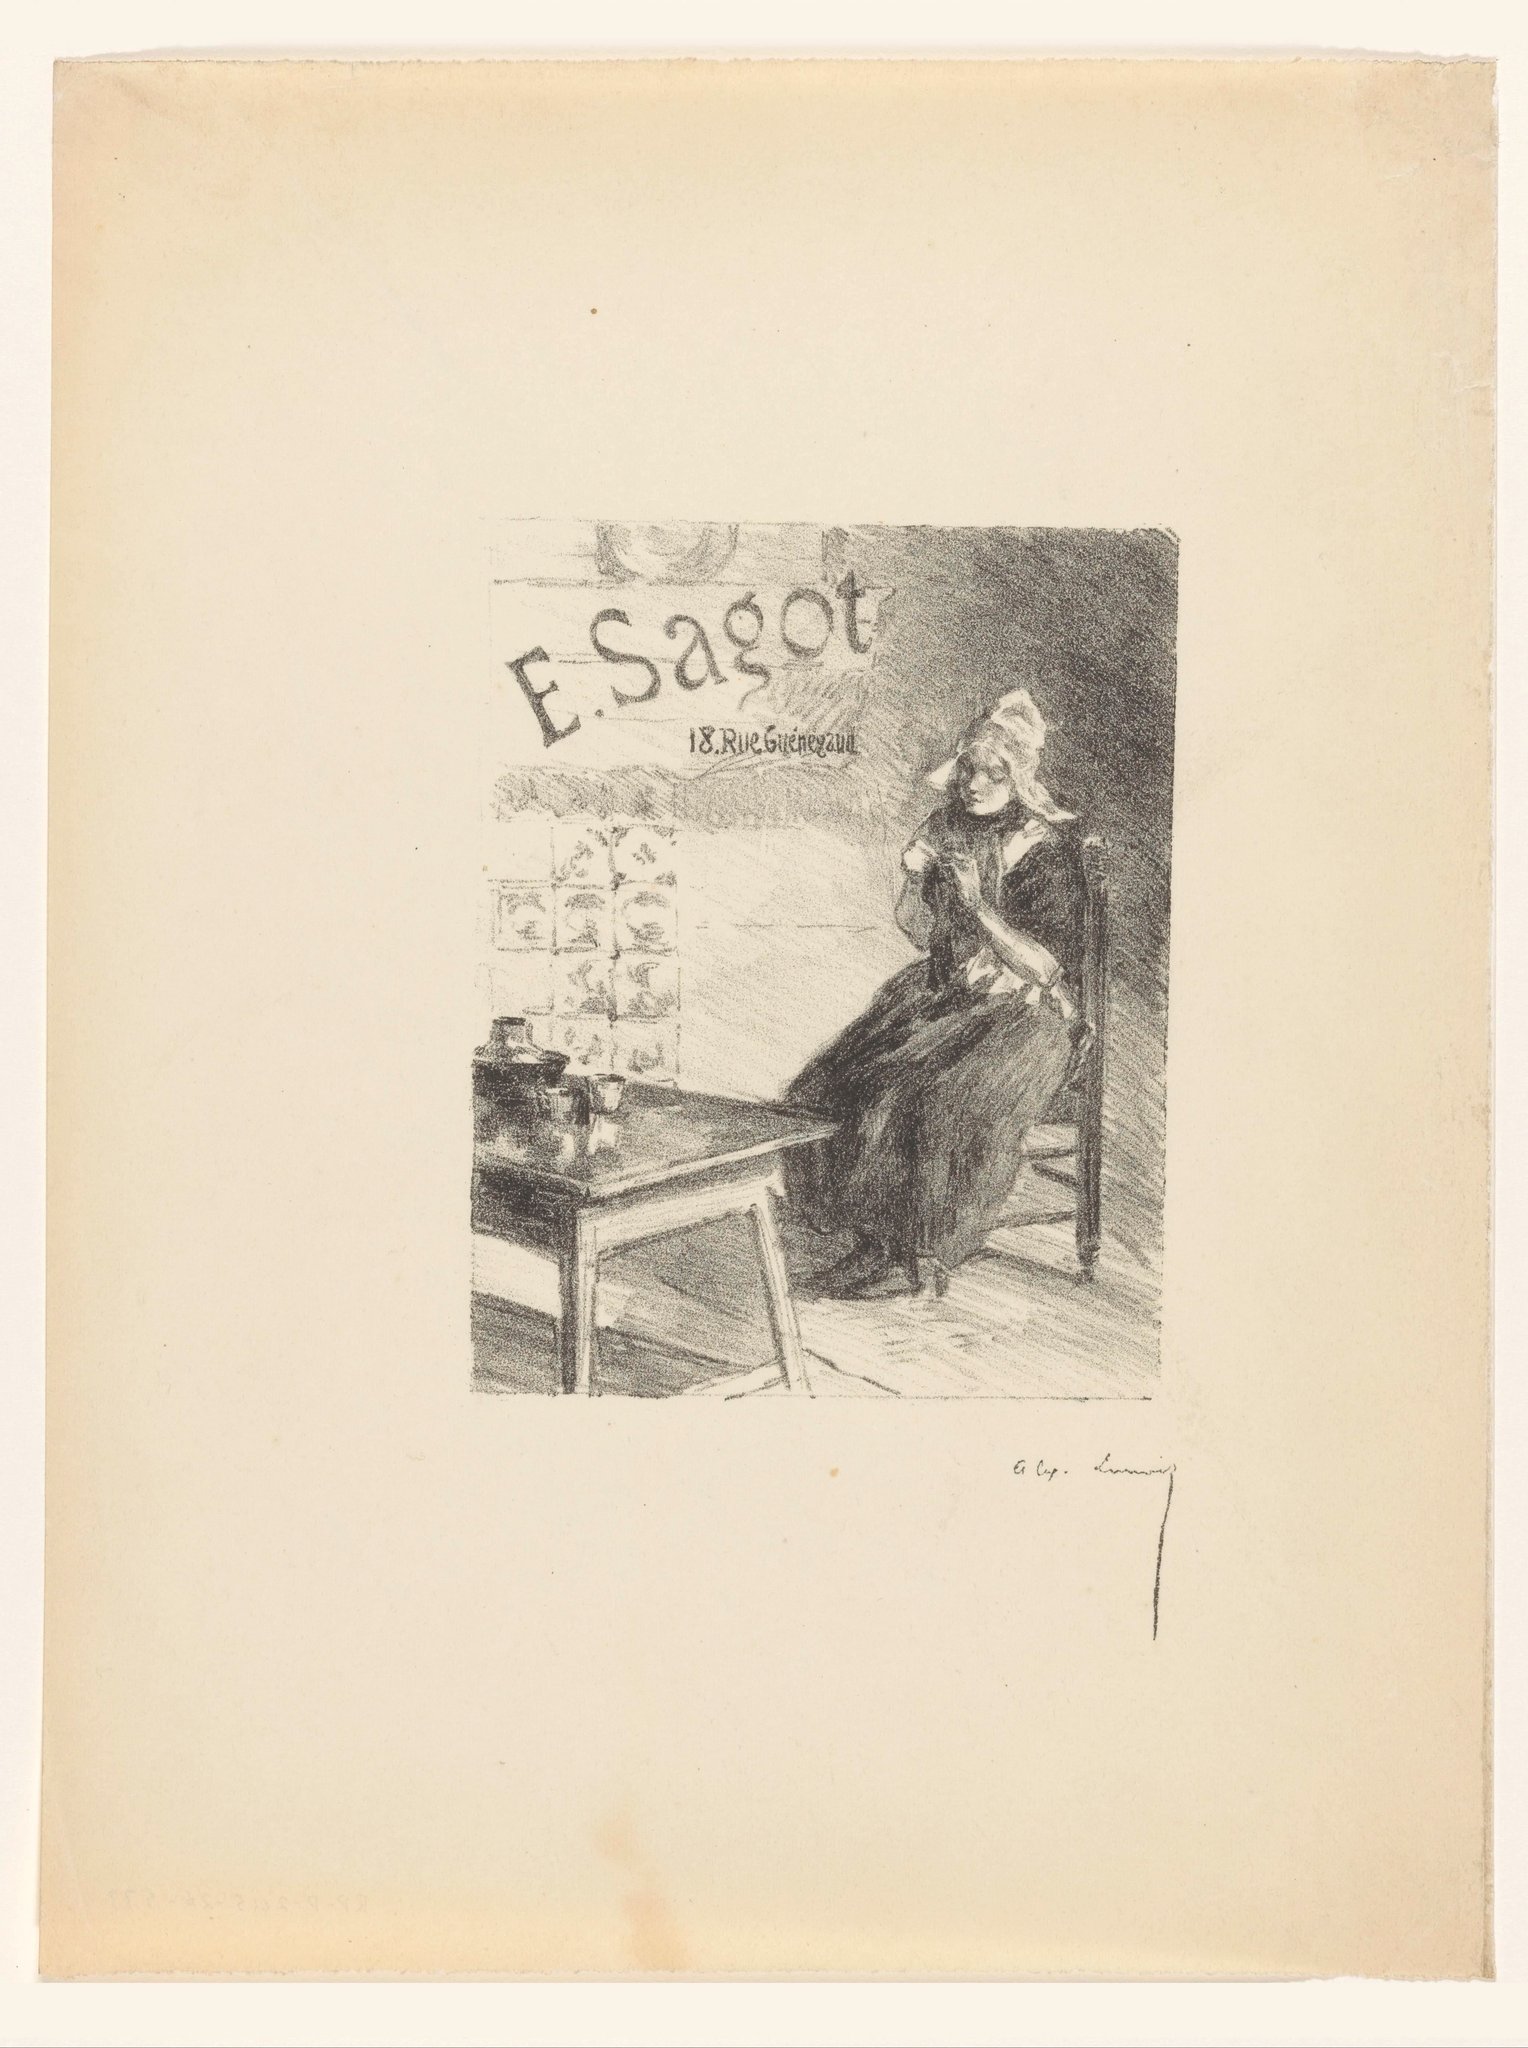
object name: visiting card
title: Visitekaartje van prenthandelaar Edmond Sagot te Parijs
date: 1881-1916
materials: paper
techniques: lithograph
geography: paris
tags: kitchen, folk costume, regional costume, sewing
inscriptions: check stamp: Lugt 225d, collector's mark: Lugt 4780, collector's mark: Lugt 2228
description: Alexandre Lunois maakte drie visitekaartjes voor Edmond Sagot, waarvan dit de tweede is. In de catalogus door Édouard André wordt deze prent beschreven als: La petite marchande de porcelaines de Delft (Jeune fille hollandaise assise tricotant).